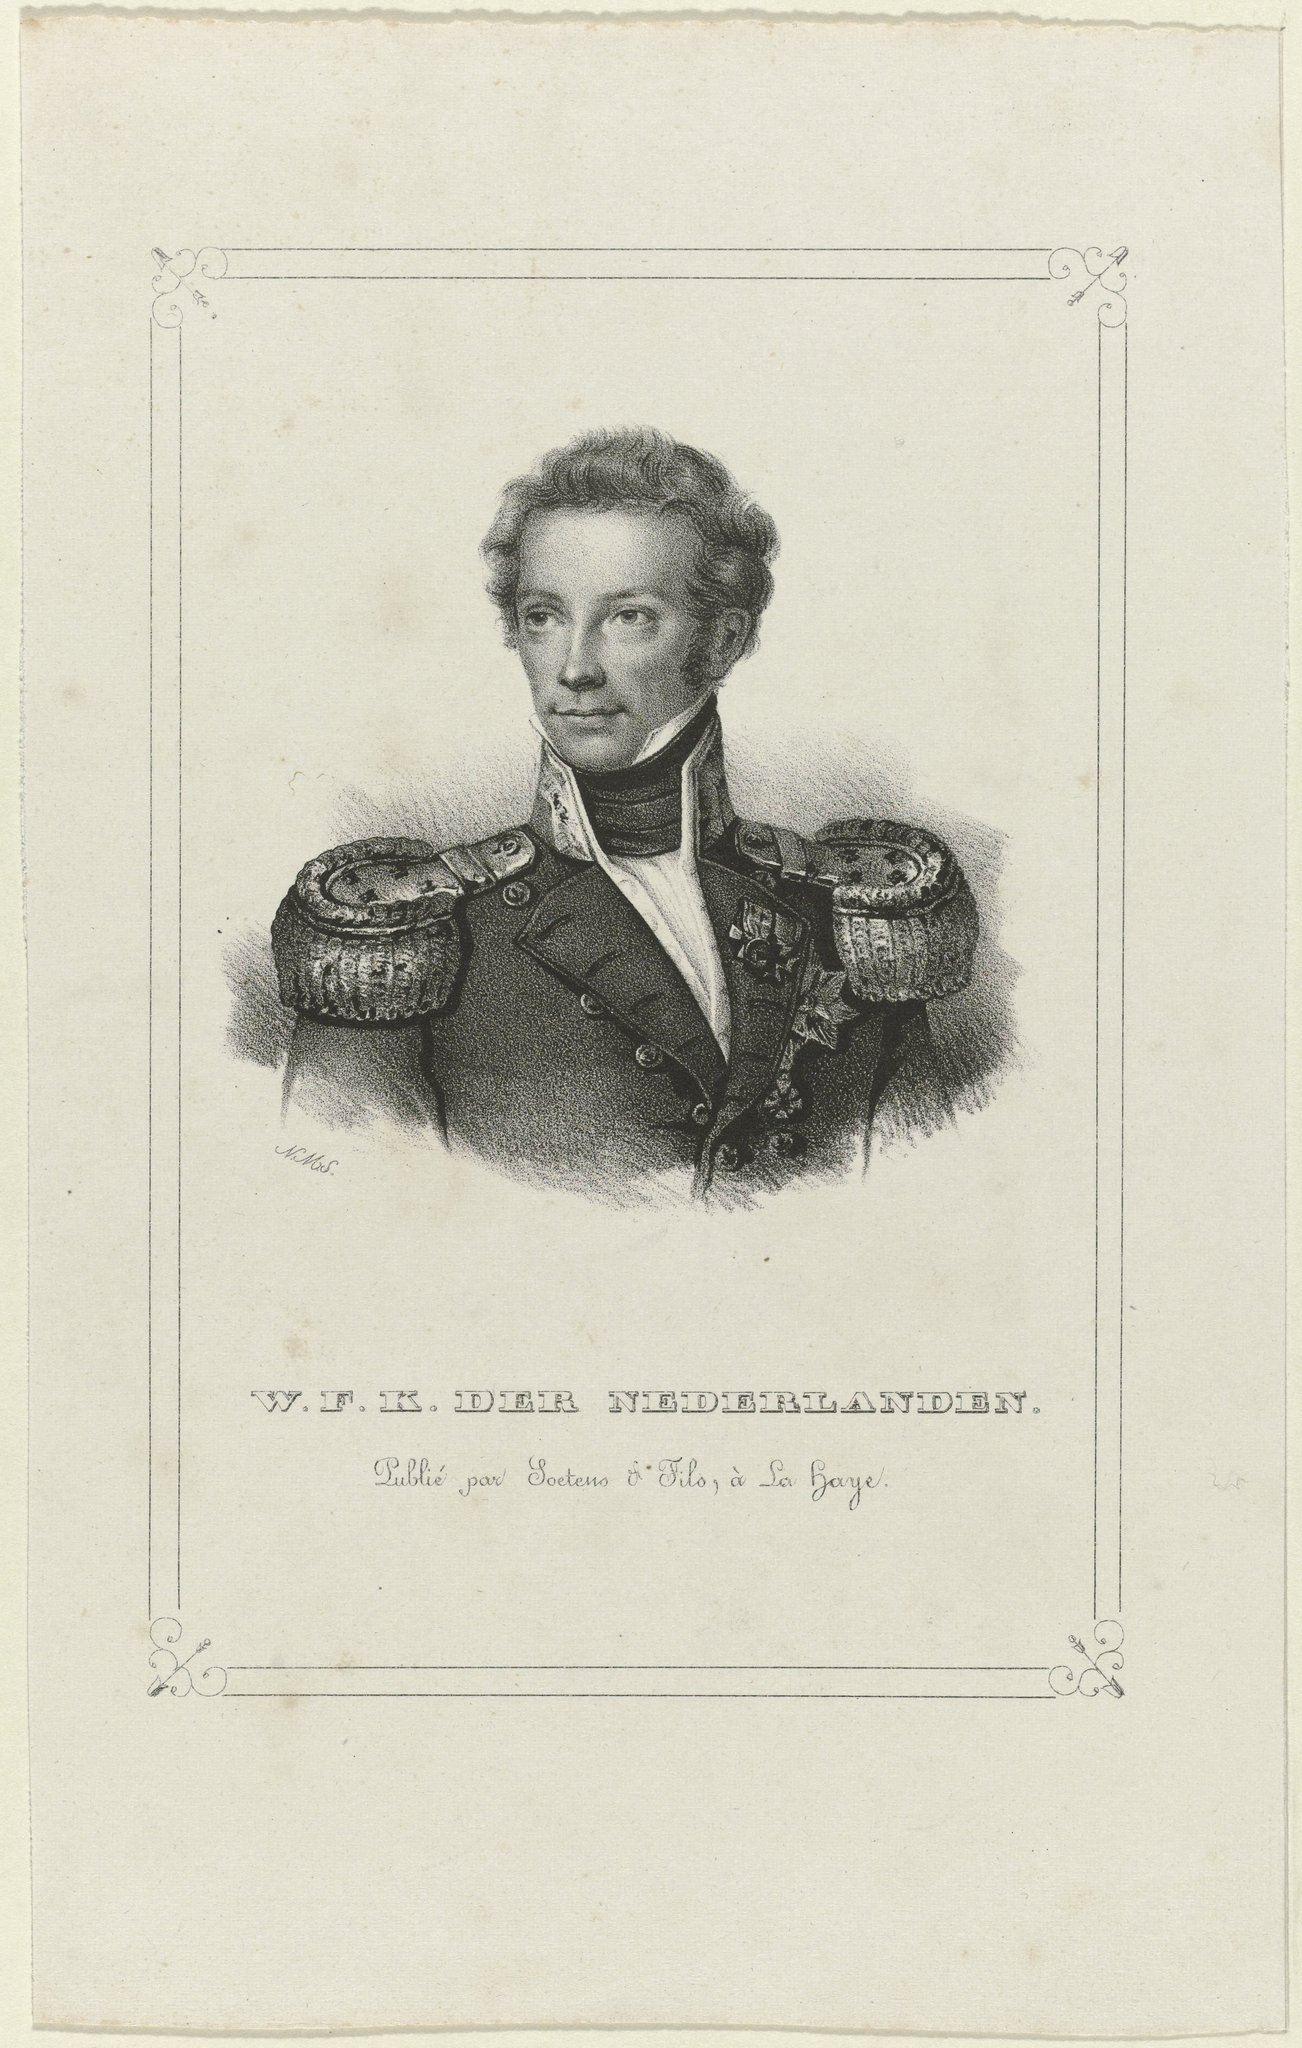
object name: print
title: Portret van Frederik, prins der Nederlanden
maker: nicolaas martinus schild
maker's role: draughtsman, print maker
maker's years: 1822-1840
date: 1837-1840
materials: paper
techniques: lithograph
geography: netherlands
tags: berlin, frederik (prins der nederlanden)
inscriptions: collector's mark: Lugt 963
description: De hier vermelde titel verwijst naar de hoogst verkregen titel van de geportretteerde, niet per se naar de titel die de geportretteerde op deze voorstelling draagt.